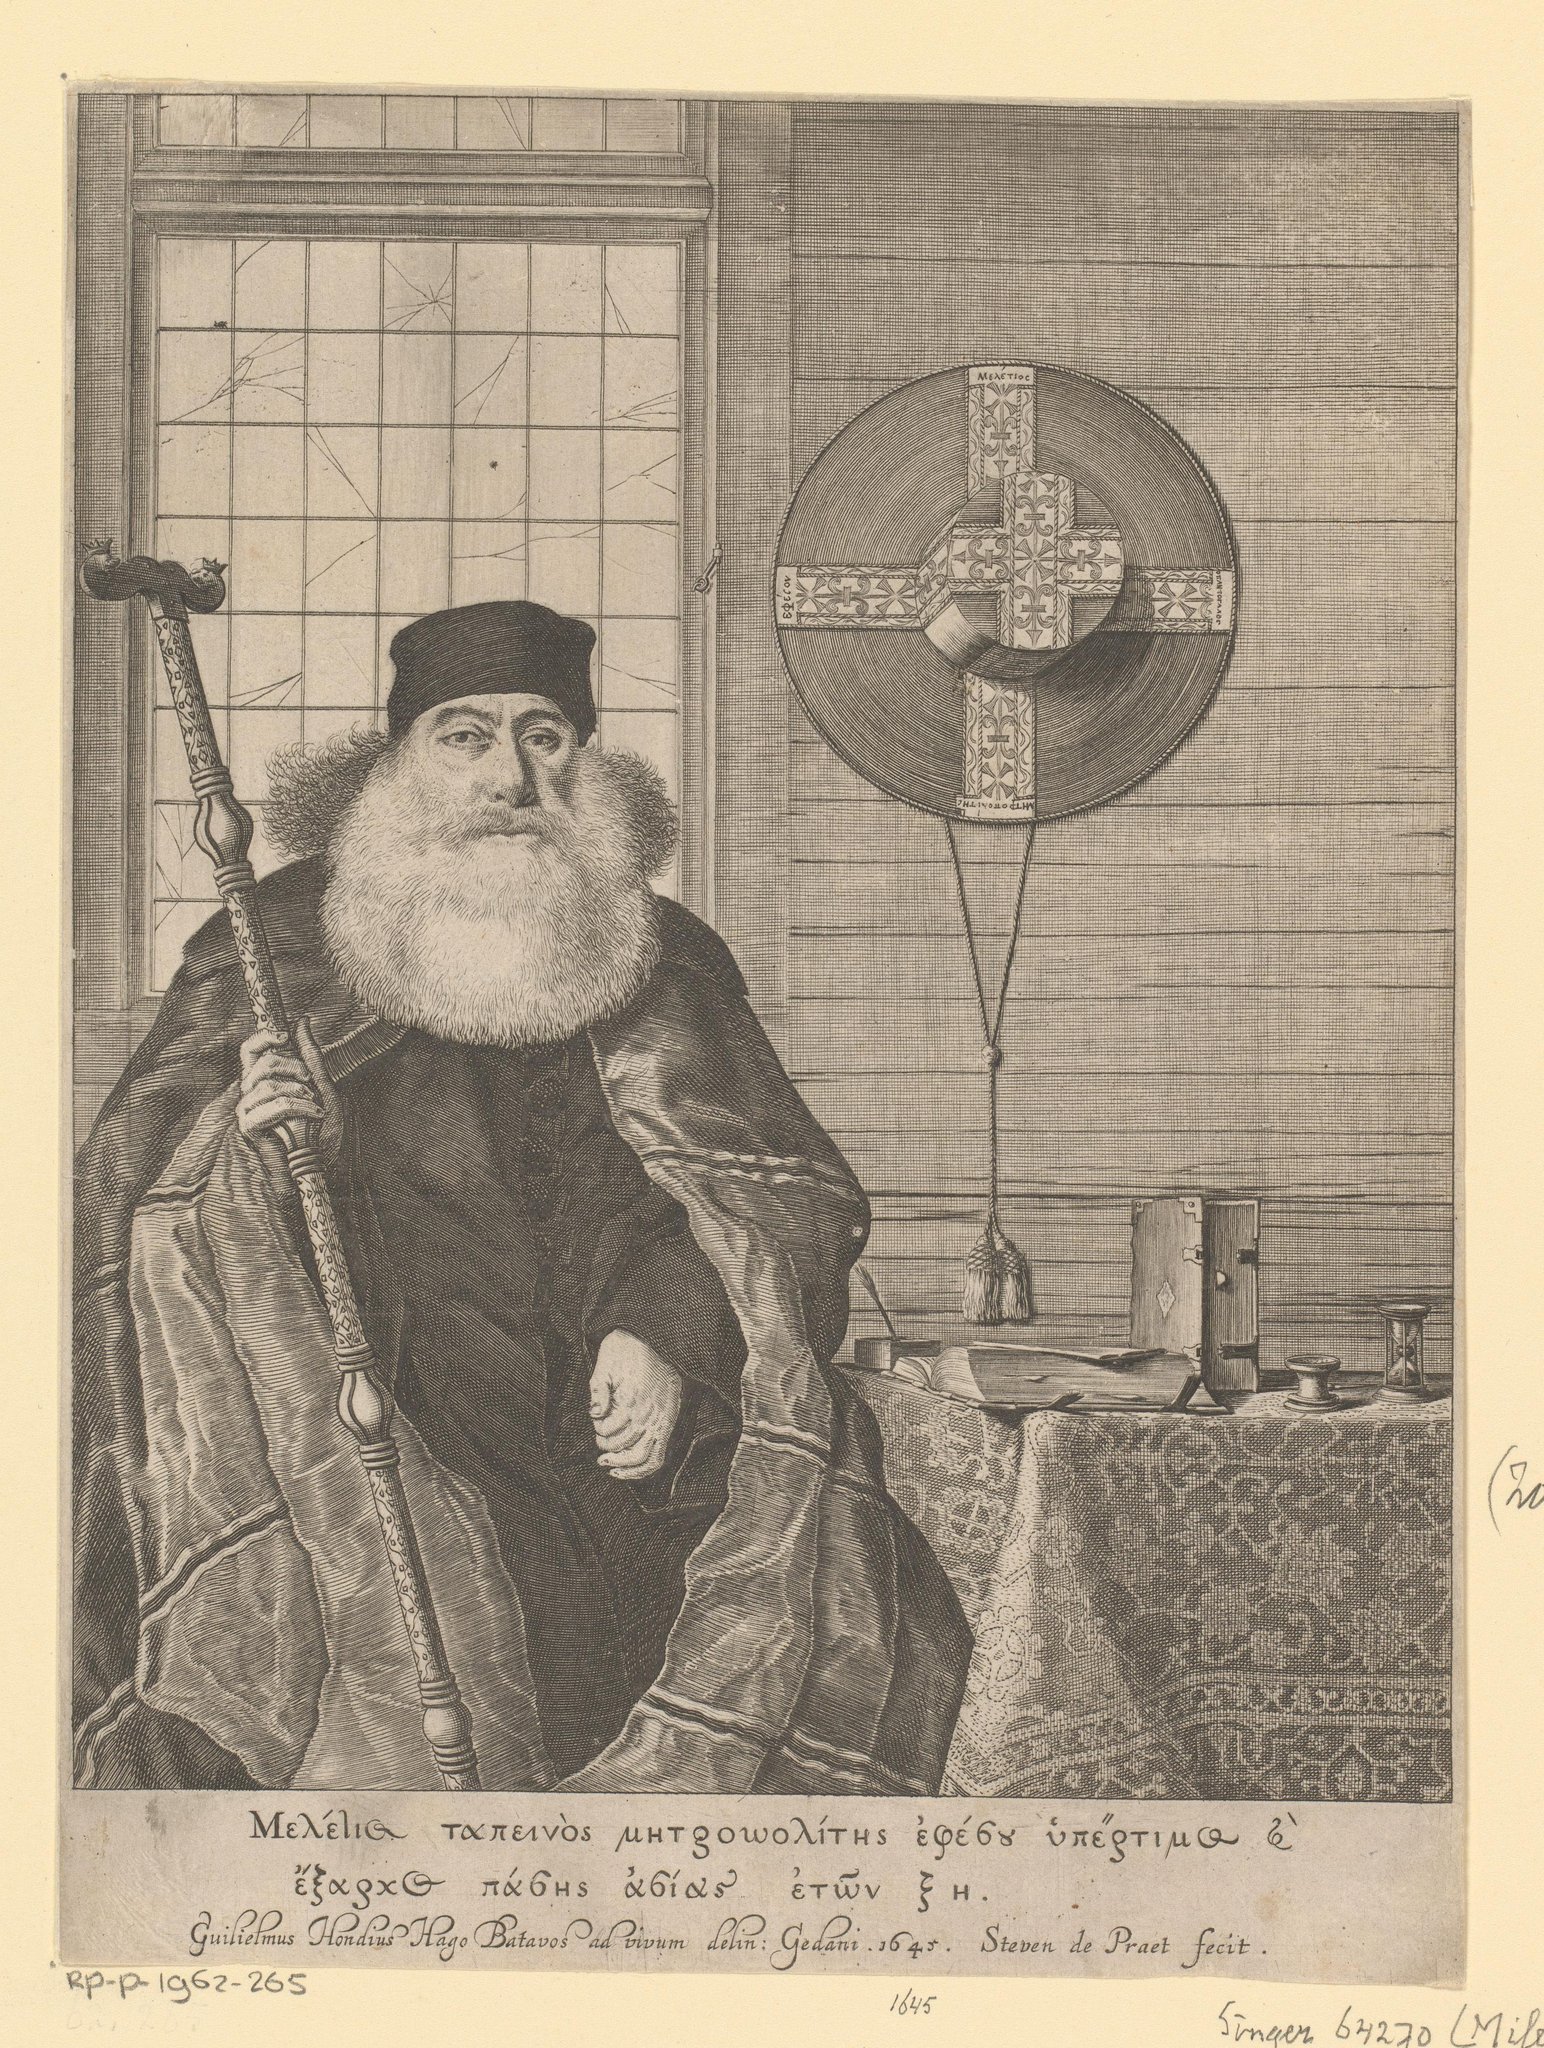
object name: print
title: Portret van Meletius Tapeinos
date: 1645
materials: paper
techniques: engraving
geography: danzig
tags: book with clasps, historical persons, hourglass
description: Met tweeregelig onderschrift in het Grieks.